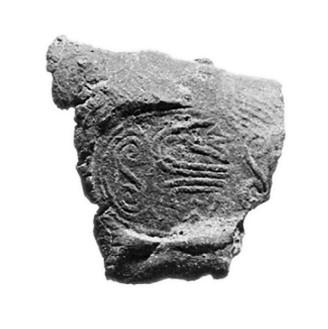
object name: sealing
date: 1981-1640 BCE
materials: mud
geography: egypt